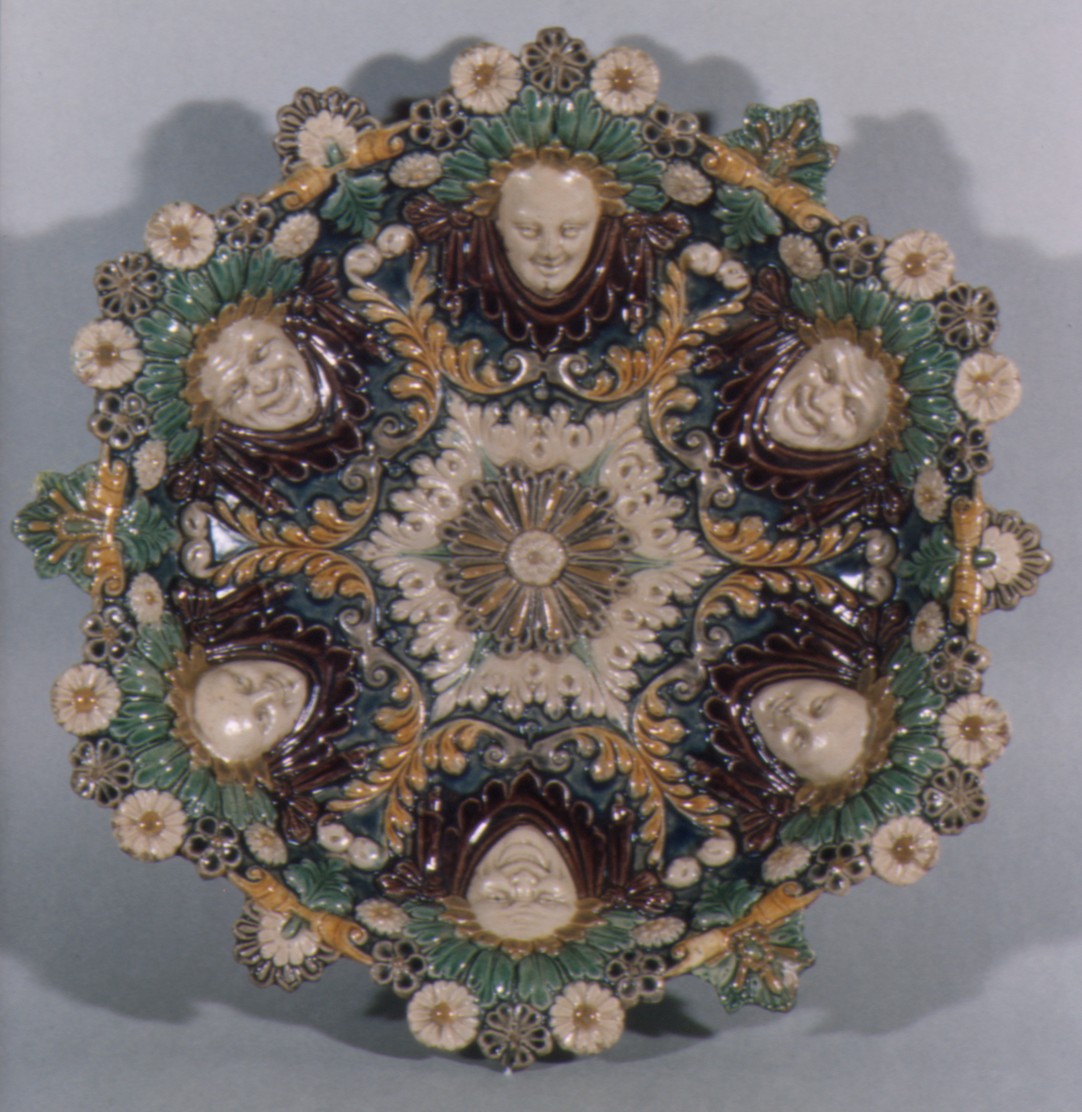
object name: dish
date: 1501-1600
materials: earthenware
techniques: glazing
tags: faces,flowers